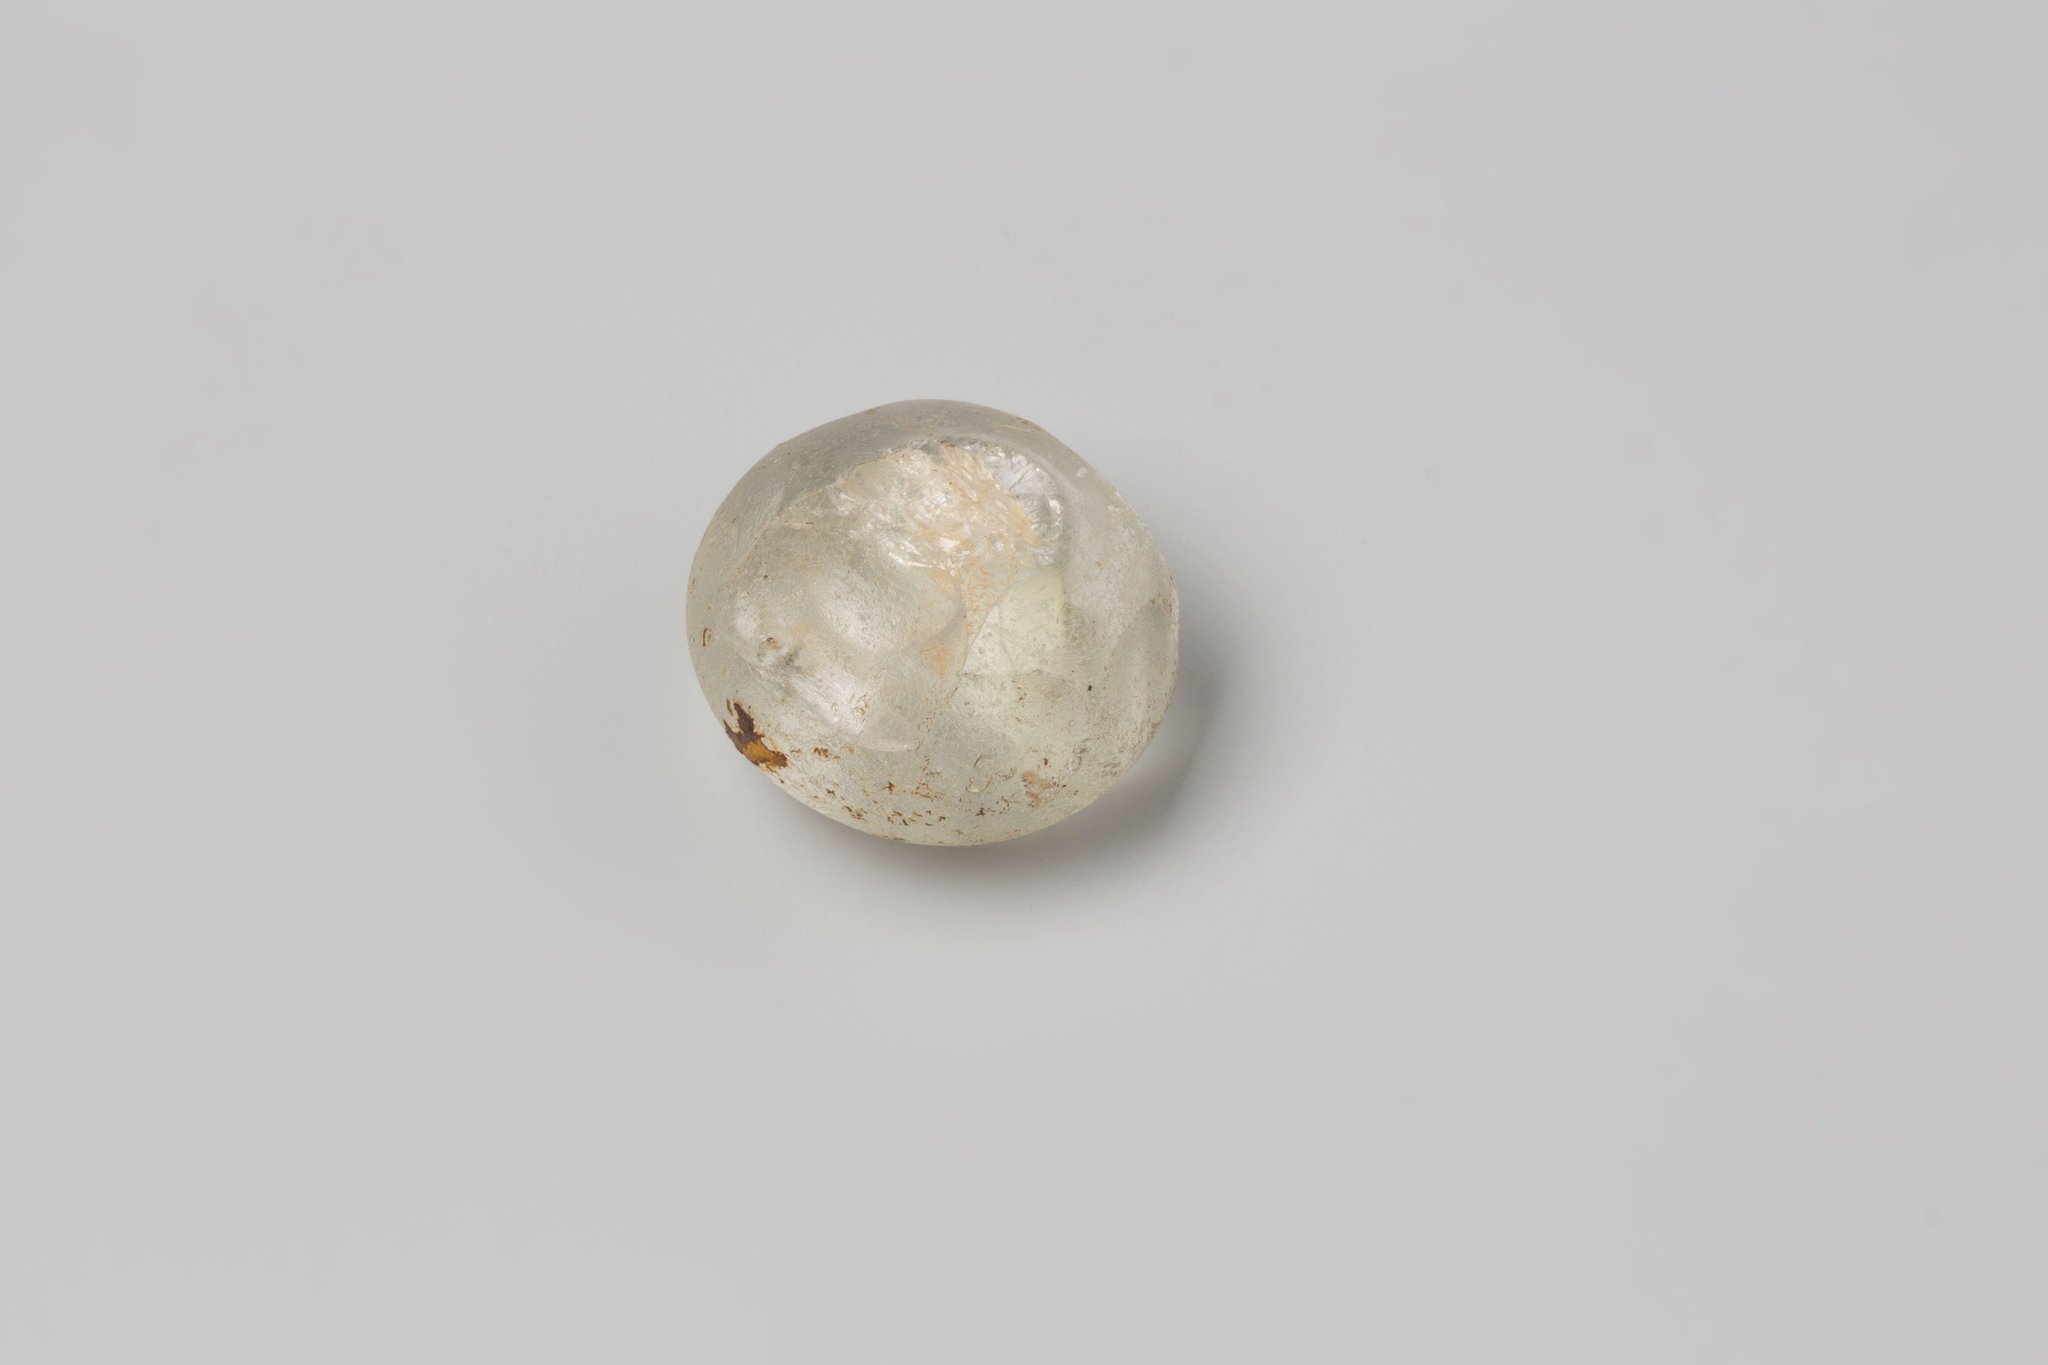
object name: drinking glass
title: Fragment gefacetteerde steel van een fluitglas uit het wrak van de Oost-Indiëvaarder Hollandia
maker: Anonymous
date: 1700-1743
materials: glass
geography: netherlands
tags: verenigde oostindische compagnie, hollandia (schip), annet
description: Glass, stem glass, steel, faceted; fragment of knop, flattened, octogonal faceted, both ends broken off.